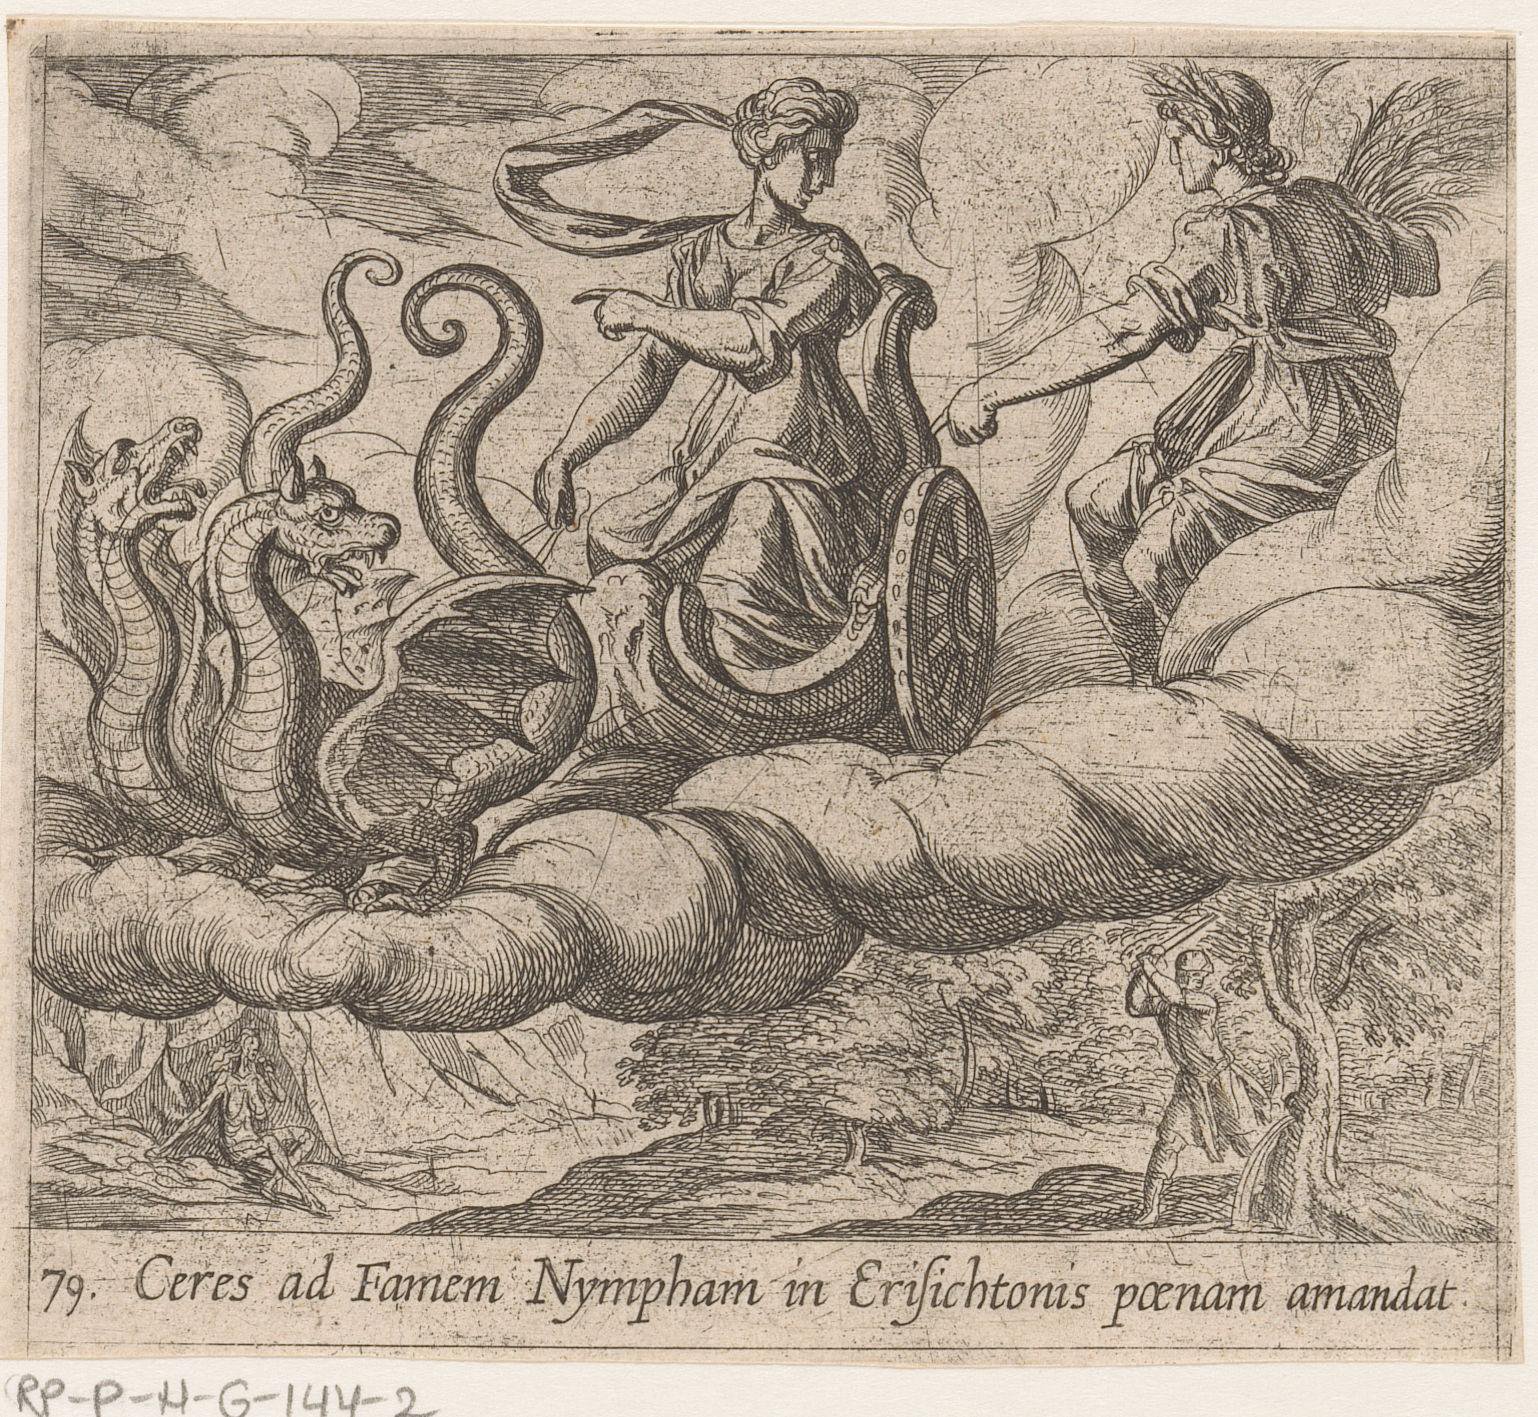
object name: print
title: Ceres ad Famem Nympham in Erisichtonis poenam amandat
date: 1606-1638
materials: paper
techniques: etching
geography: italy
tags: a nymph is sent to fames in ceres' chariot, in order to punish erysichthon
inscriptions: collector's mark: ‘Hinloopen’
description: Een nimf in de wagen van Ceres wordt door Ceres naar Erysichthon gestuurd om hem te bestraffen. Titel in het Latijn in ondermarge.